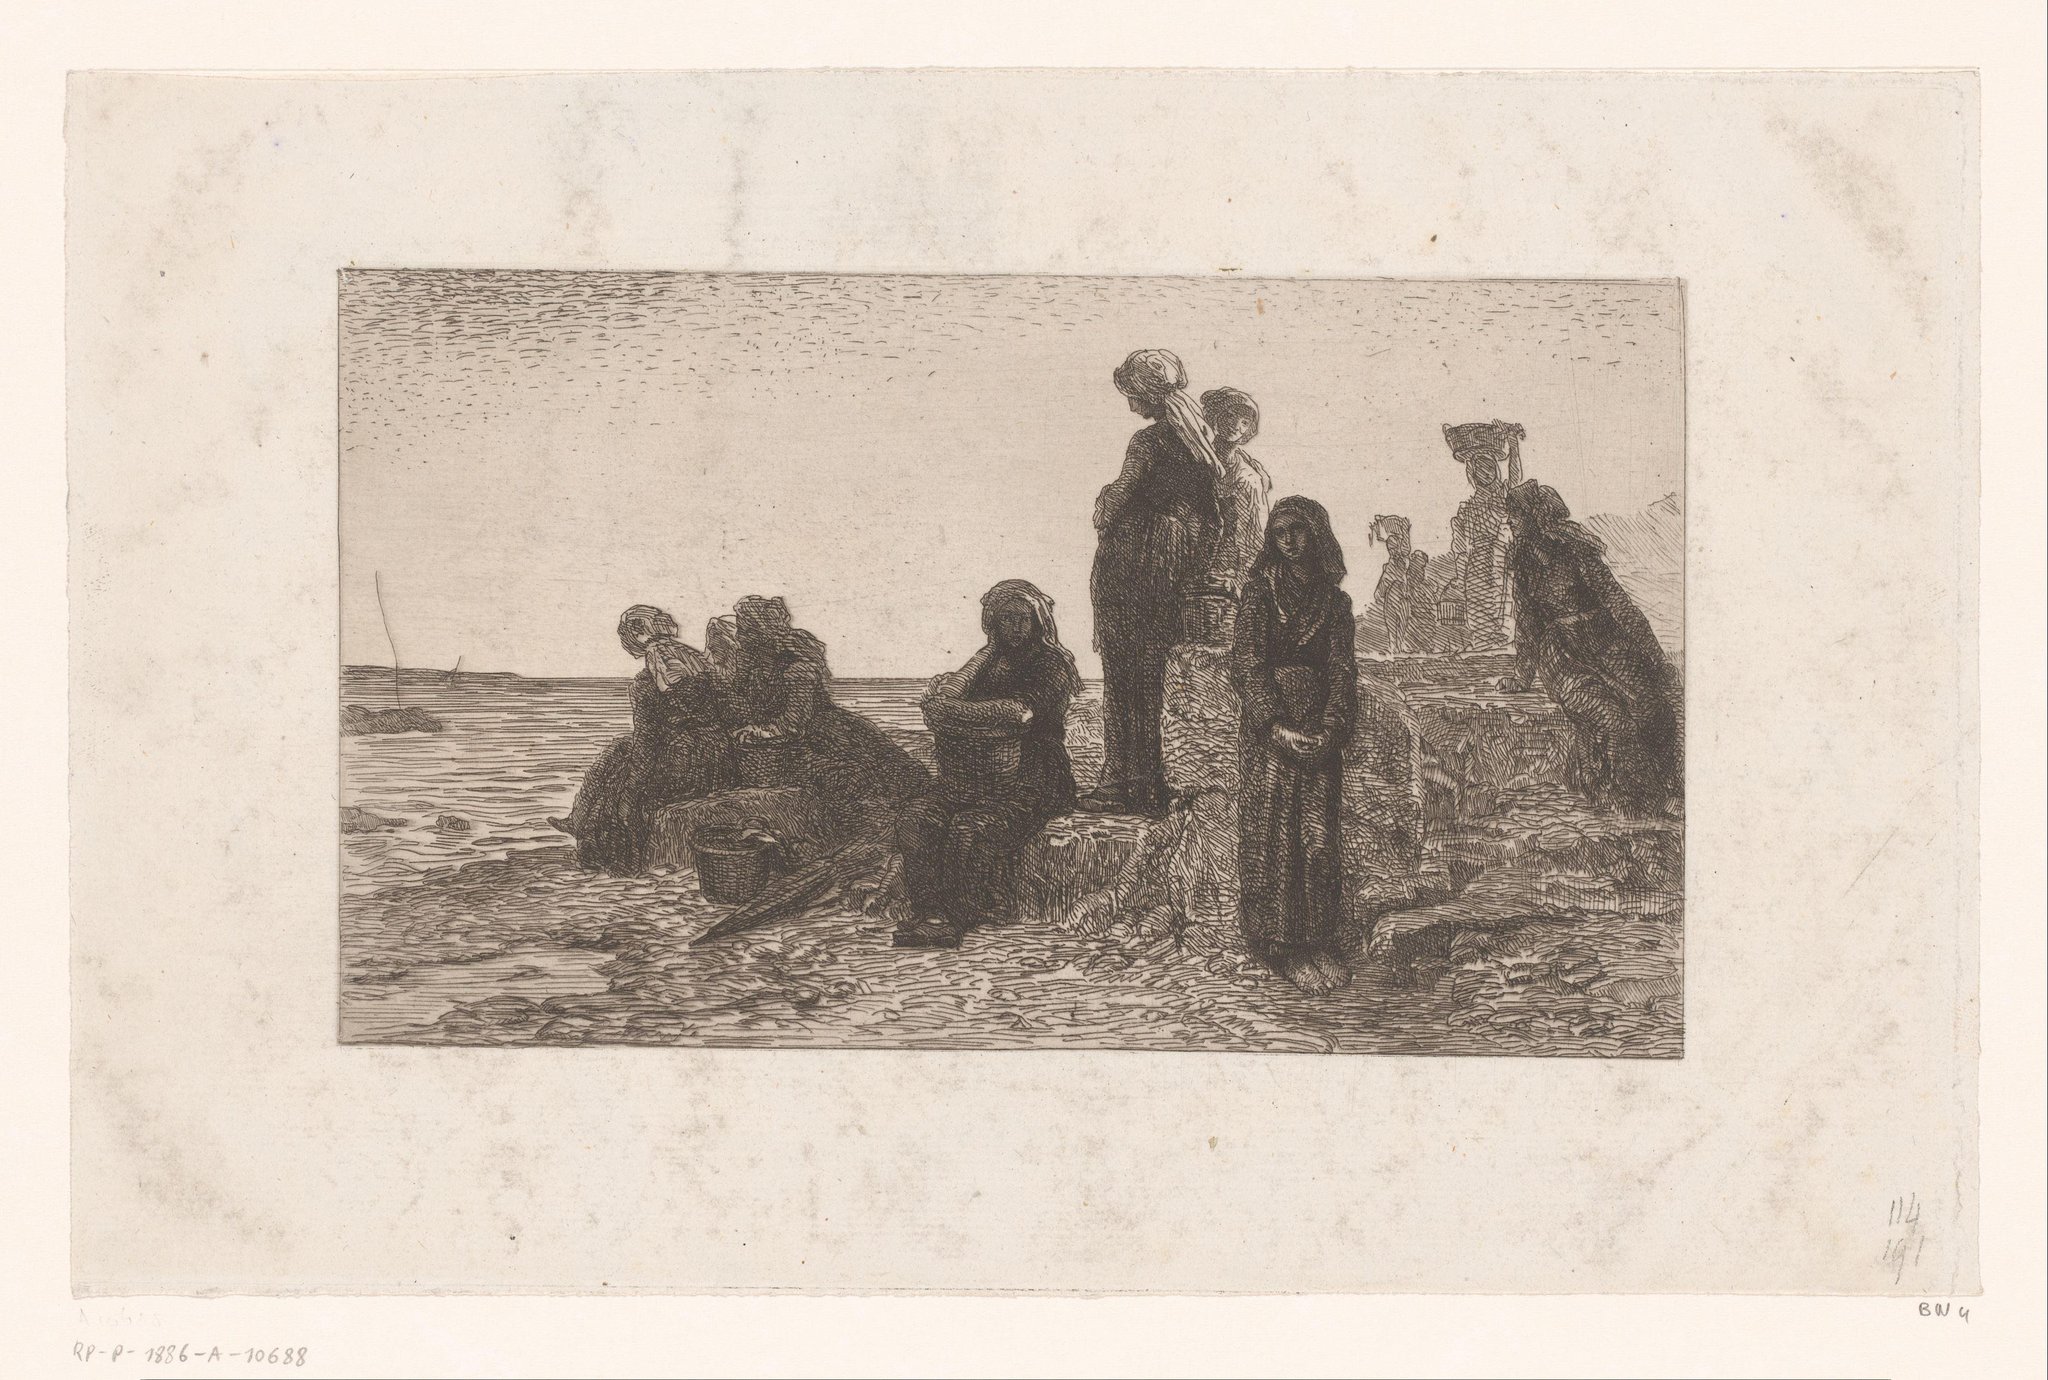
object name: print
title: Rustende vissersvrouwen aan het water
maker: françois-nicolas-augustin feyen-perrin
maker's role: print maker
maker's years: 1826-1888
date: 1867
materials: paper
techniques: drypoint, etching, intaglio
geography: france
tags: coast, fisherman, resting - bb - out of doors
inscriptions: collector's mark: Lugt 2228